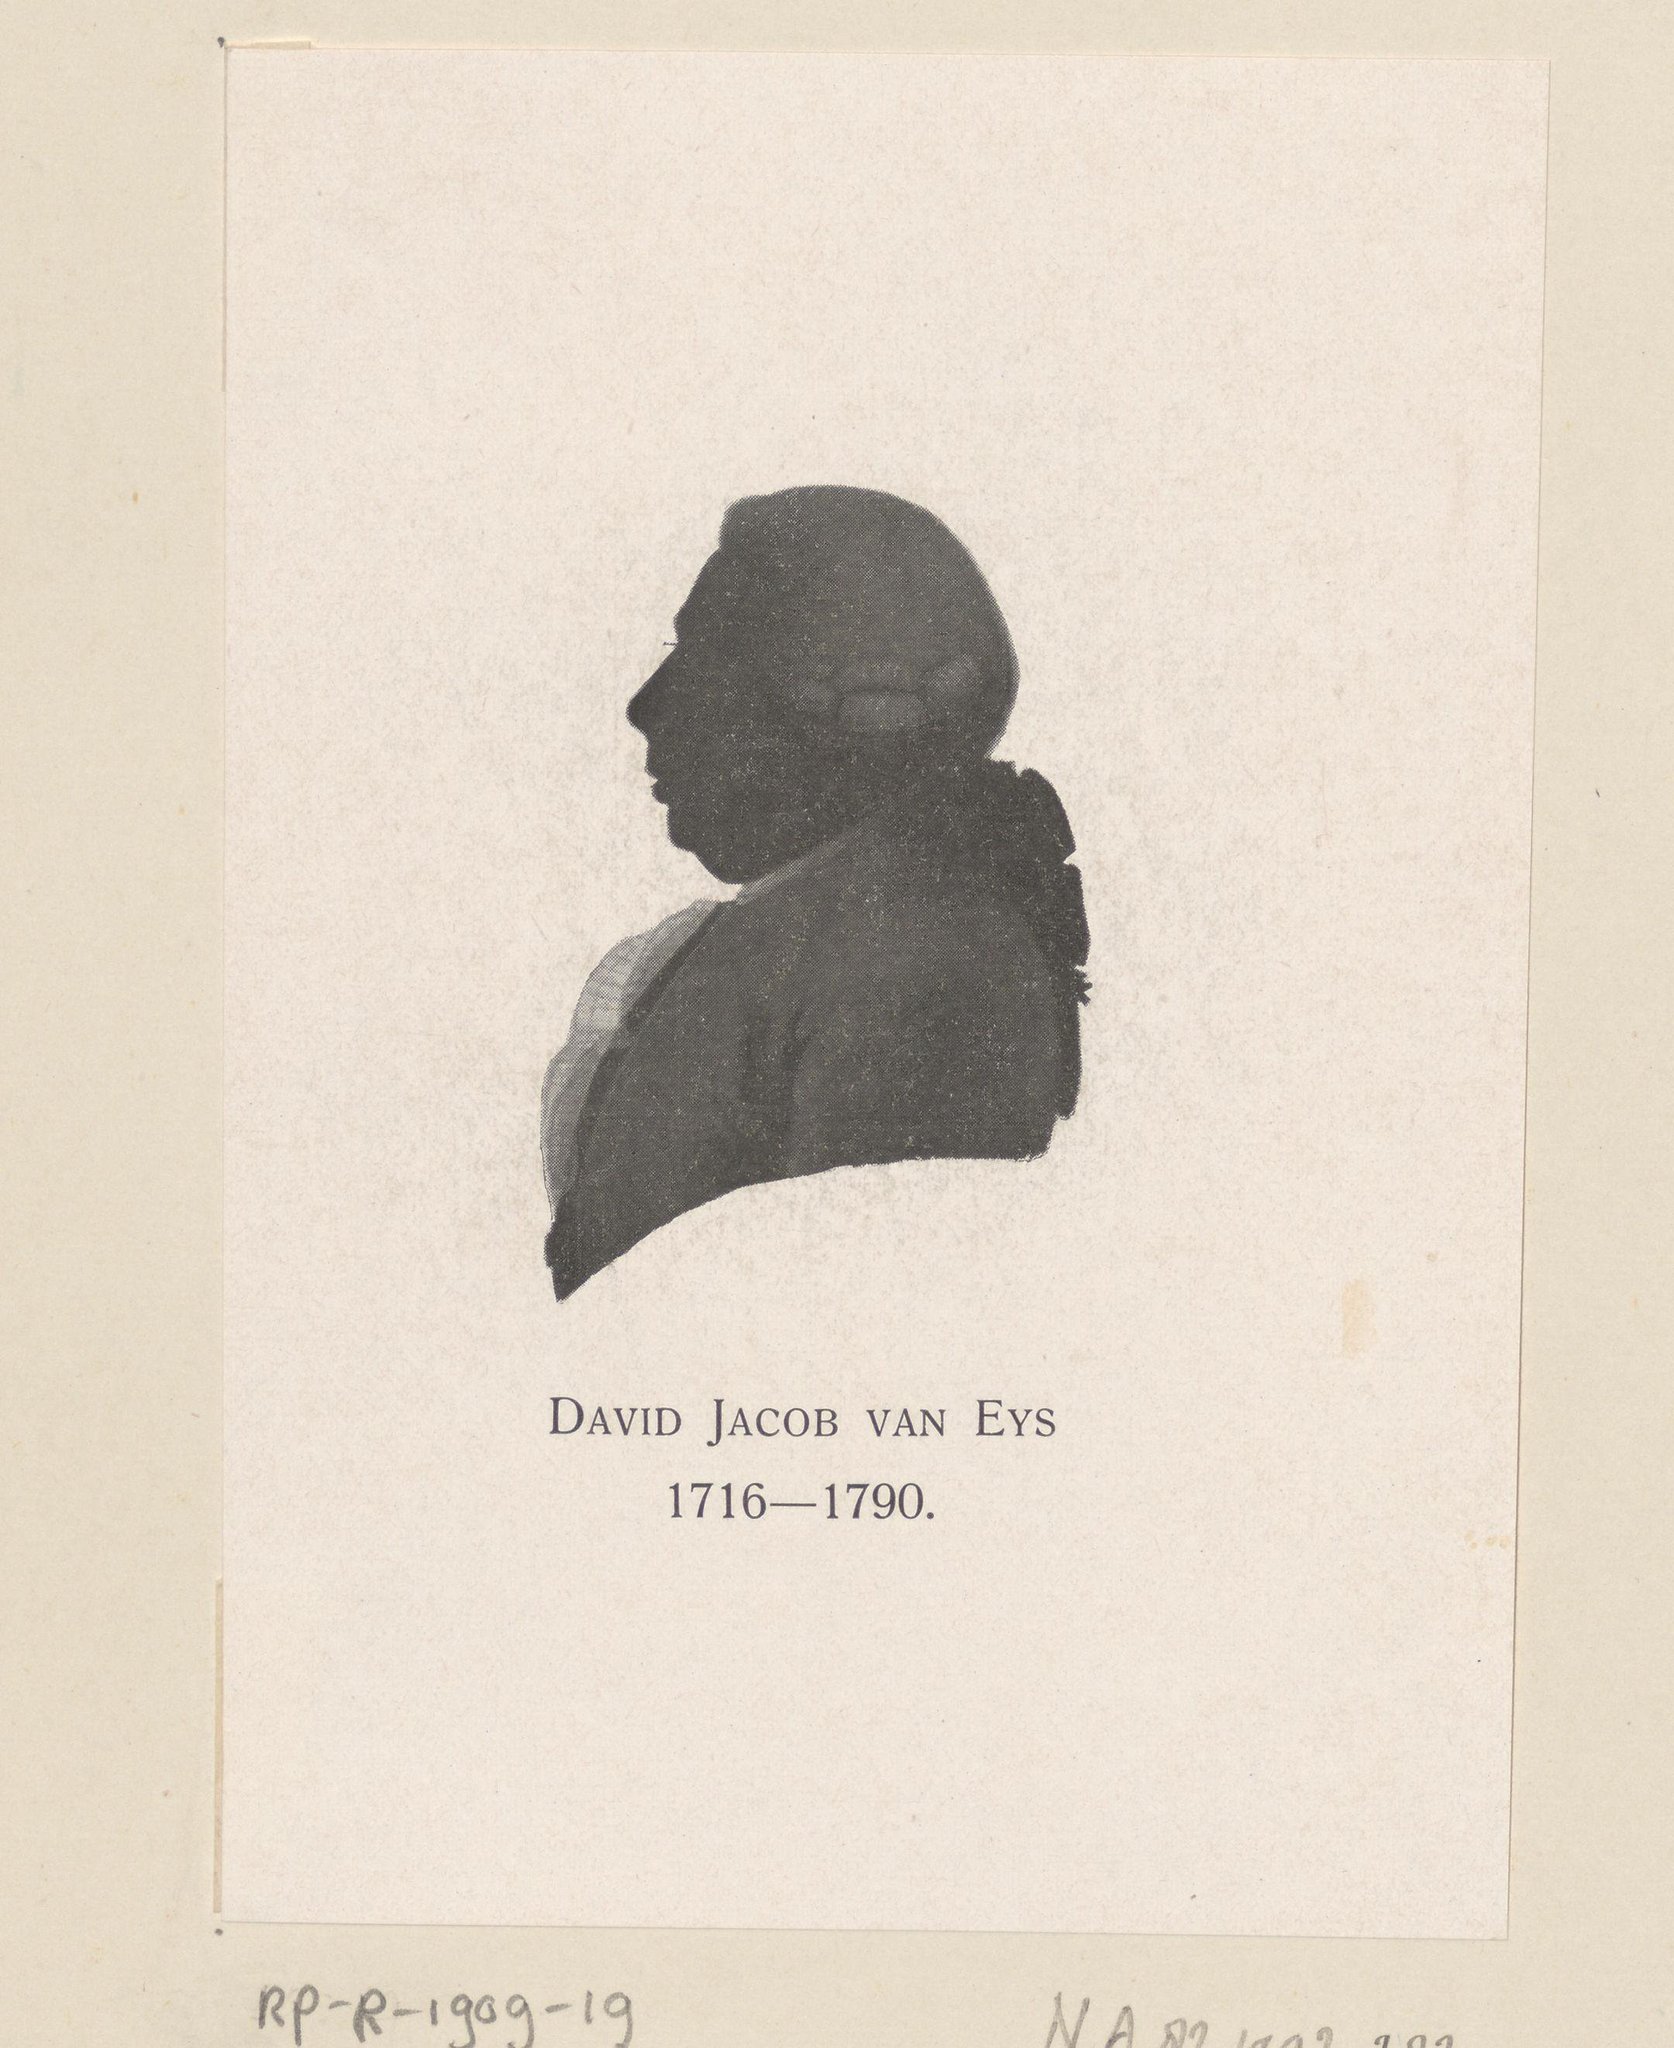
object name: photomechanical print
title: Silhouetportret van David Jacob van Eys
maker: Anonymous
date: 1890-1909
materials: paper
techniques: autotype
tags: historical persons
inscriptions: collector's mark: Lugt 2228